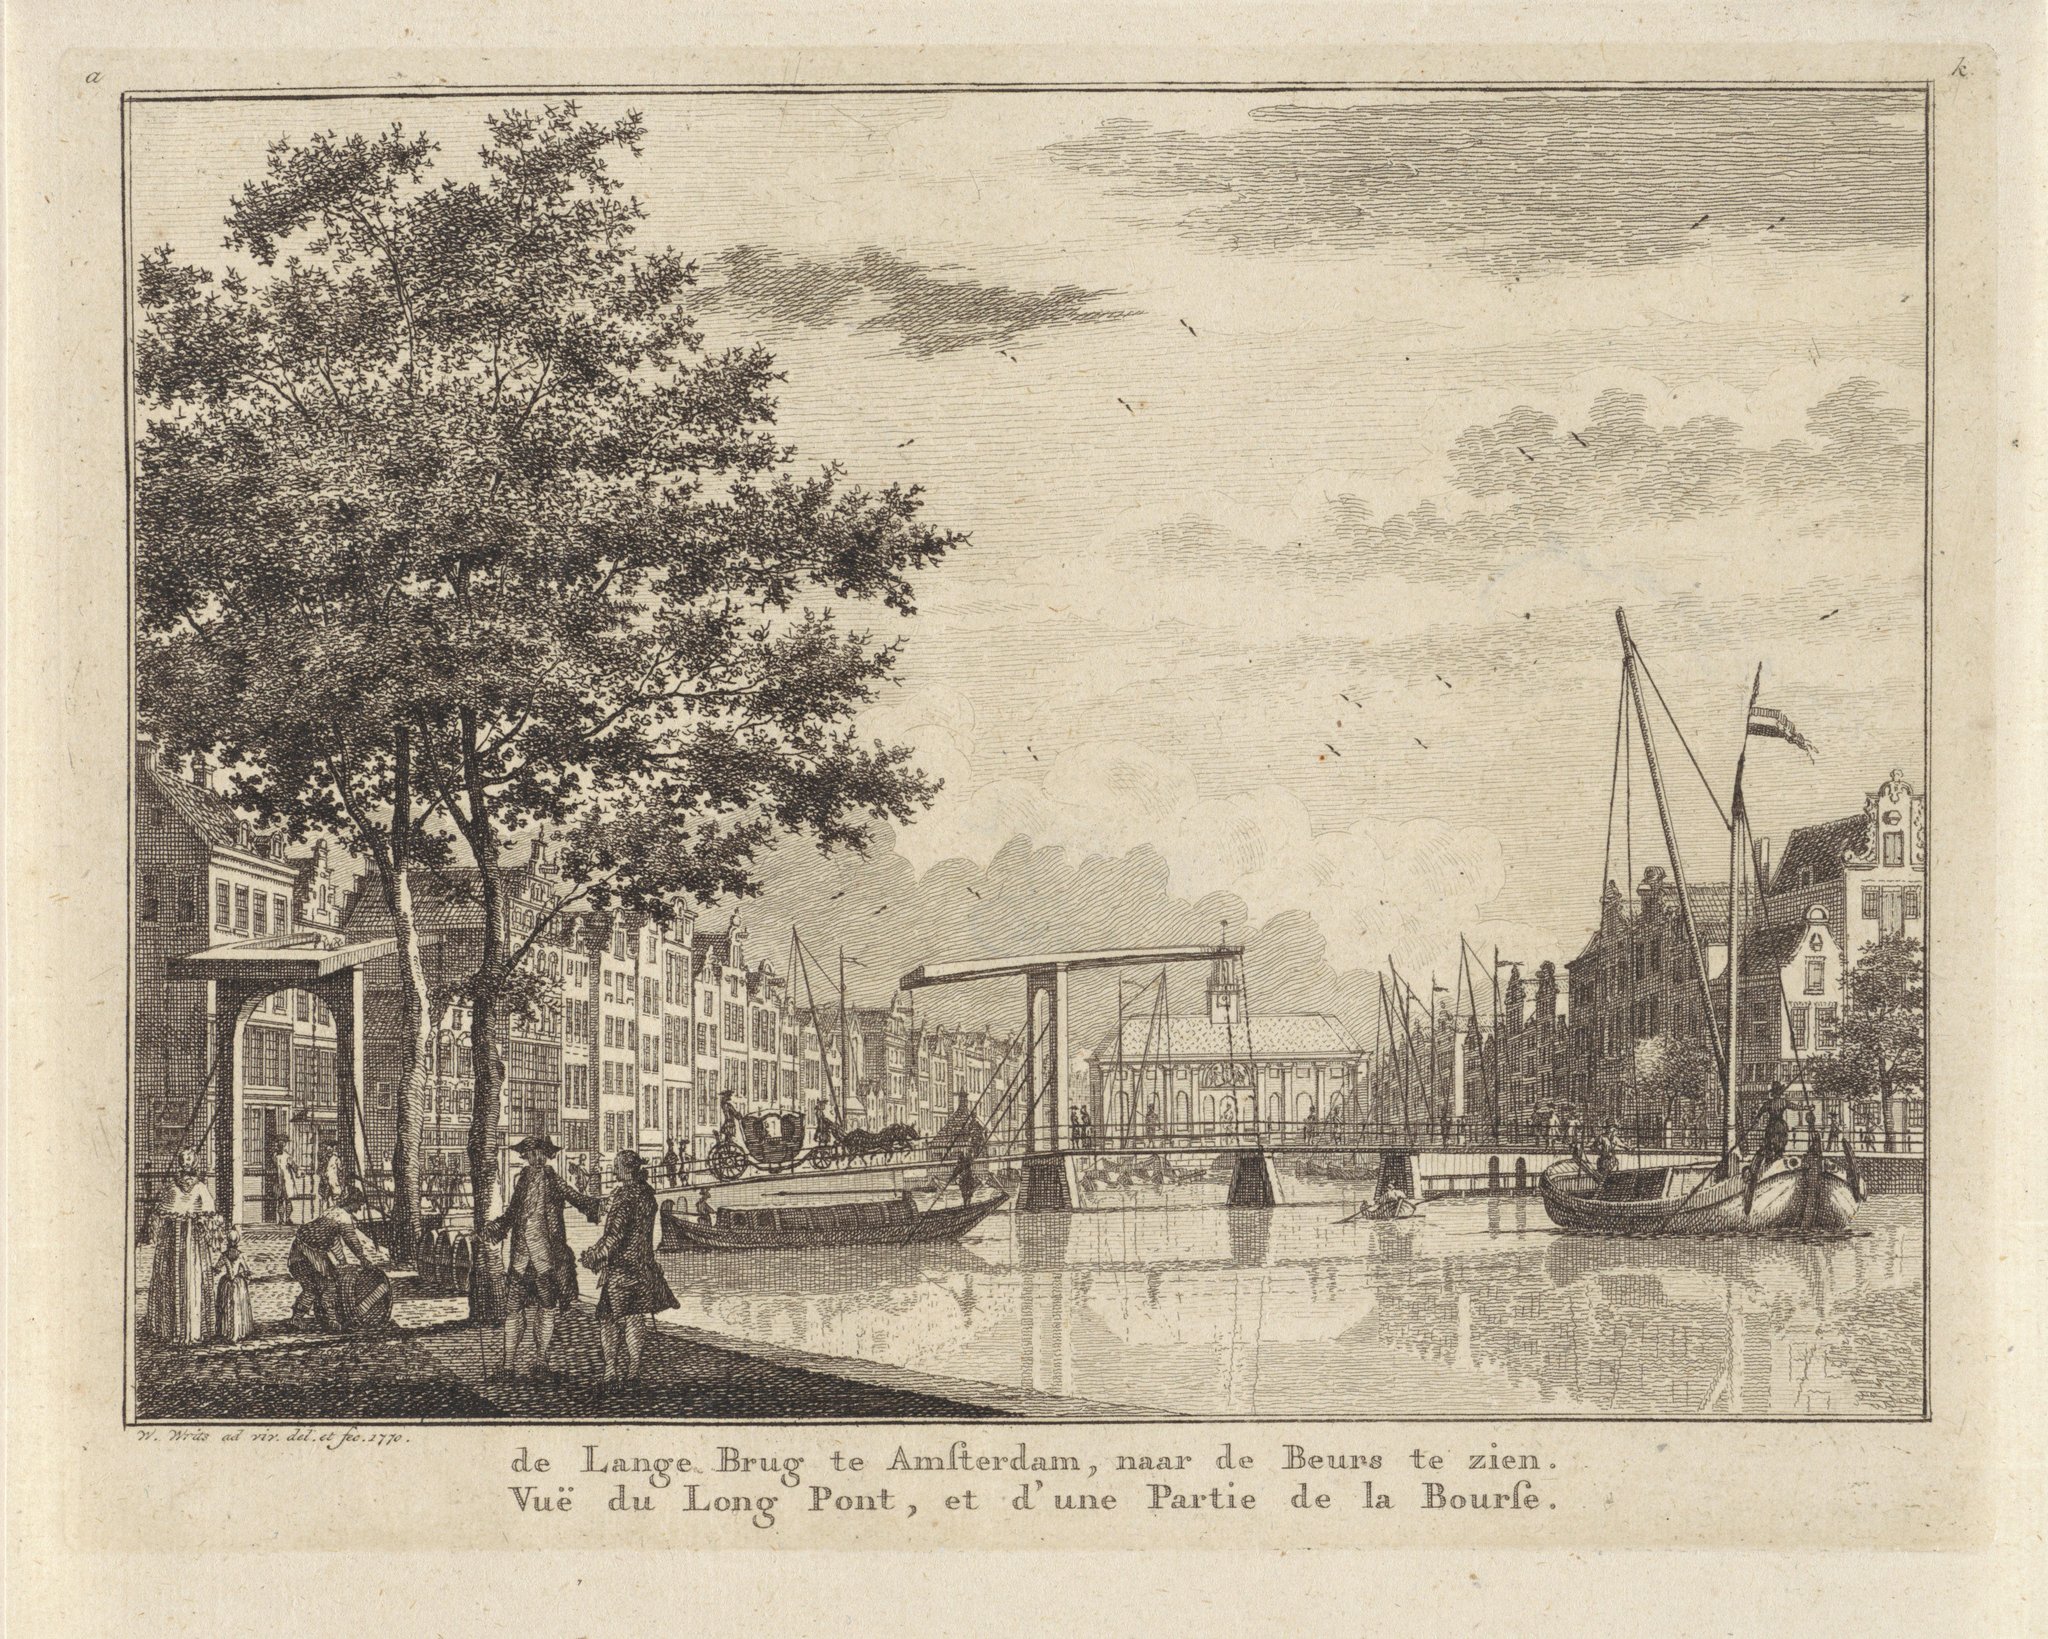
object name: print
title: de Lange Brug te Amsterdam, naar de Beurs te zien.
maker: willem writs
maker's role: draughtsman, print maker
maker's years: 1731-1786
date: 1770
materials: paper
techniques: etching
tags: bridge, amsterdam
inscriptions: collector's mark: Lugt 2228